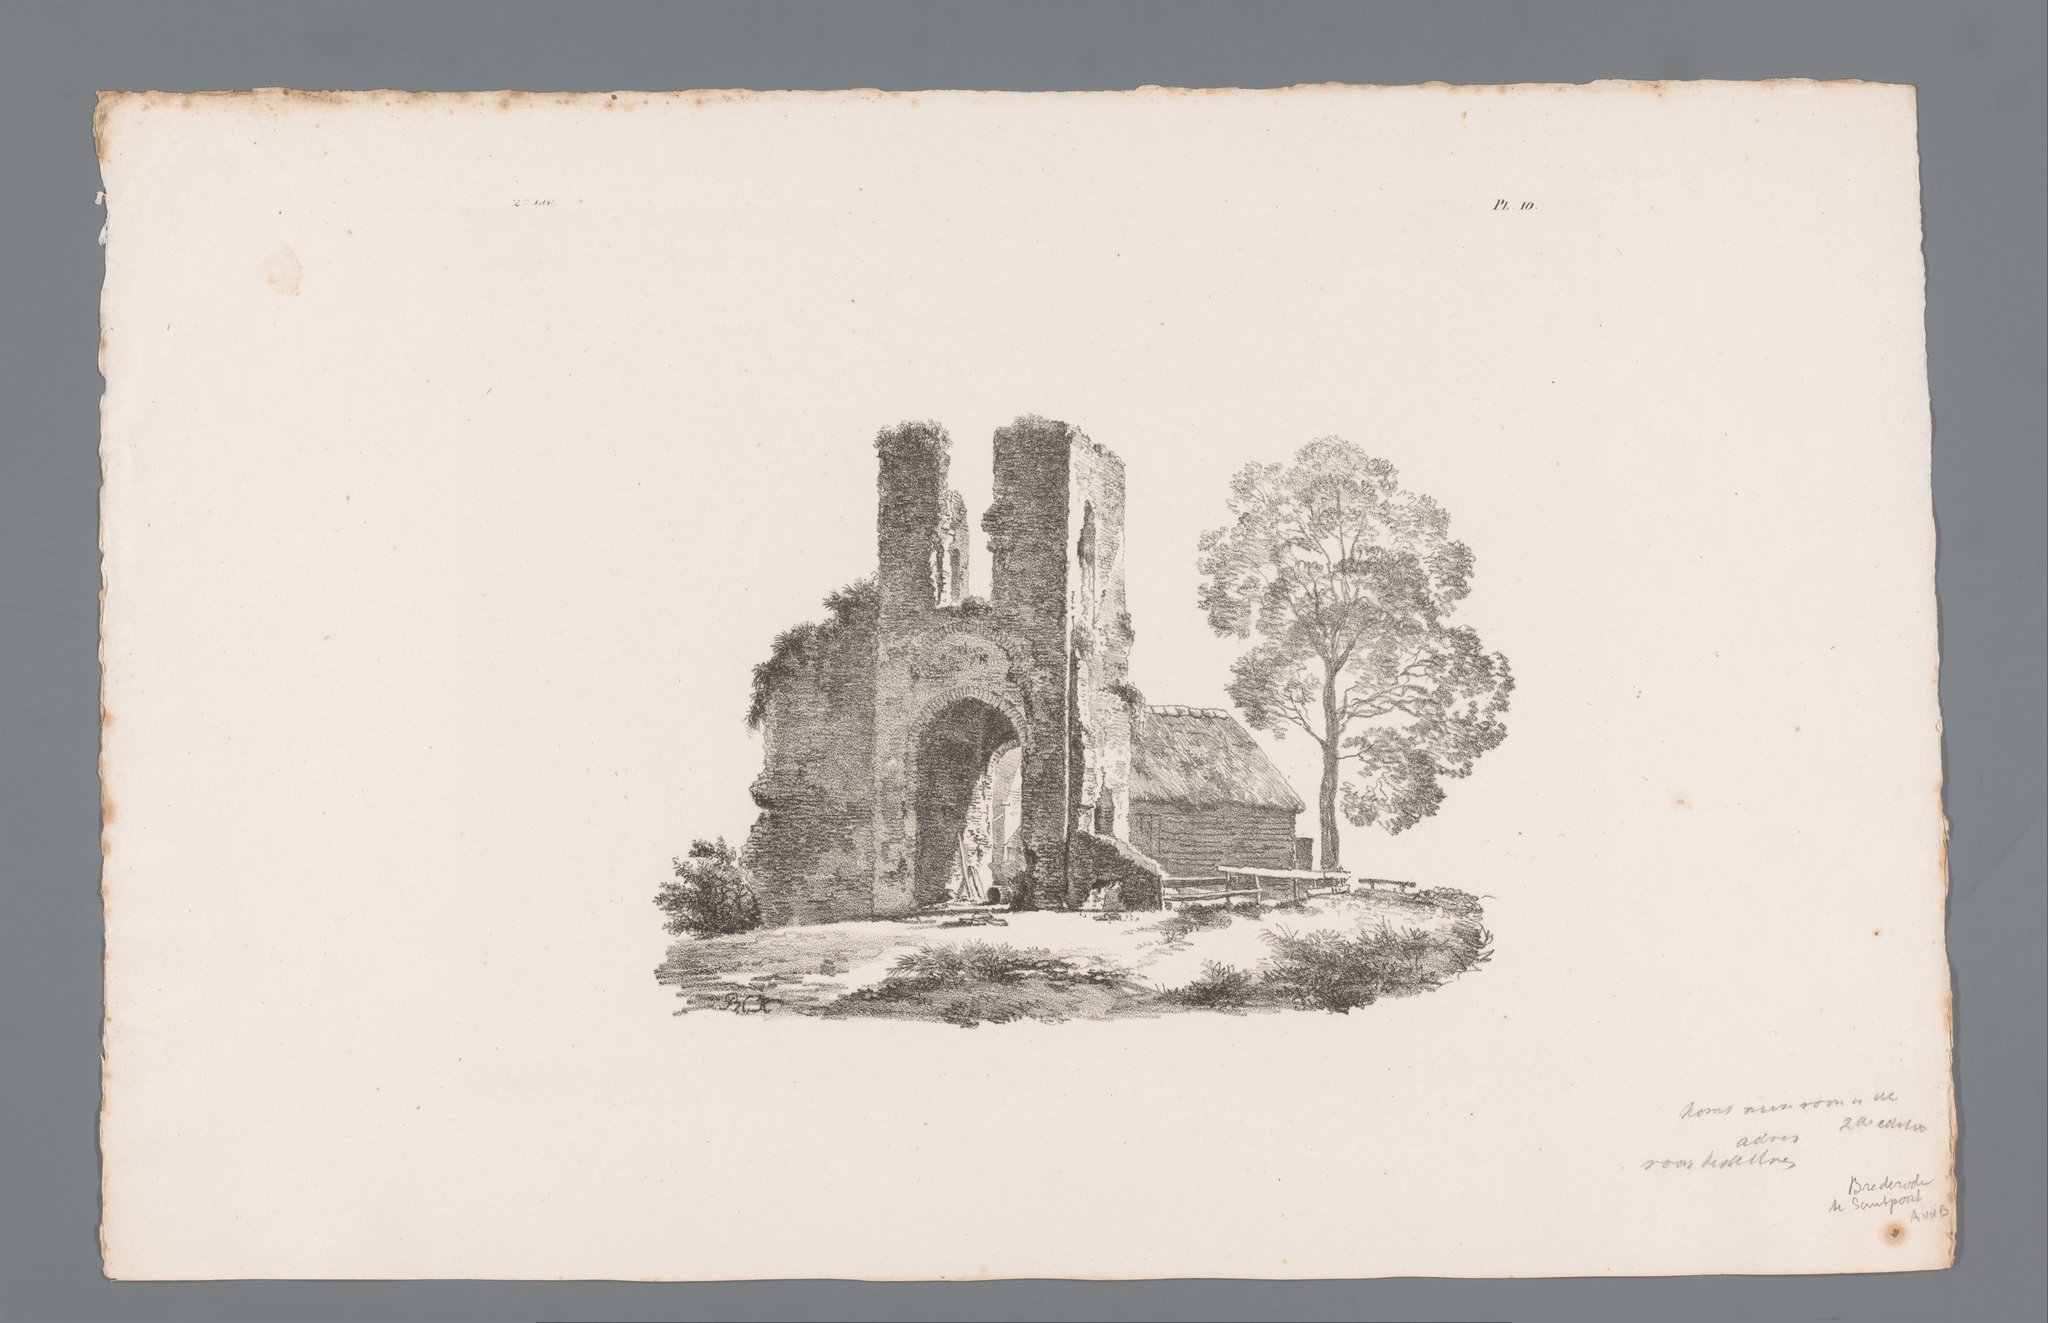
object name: print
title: Ruïne met boerderij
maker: barend cornelis koekkoek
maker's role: draughtsman, painter, print maker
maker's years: 1803-1862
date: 1829-1844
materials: paper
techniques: lithograph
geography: amsterdam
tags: ruin of a building ~ architecture, farm (building)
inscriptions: inscription: ‘Komt niet voor in de / 2e editie / adres / voor het adres / Brederode / te Santpoort / AvdB’, collector's mark: Lugt 2228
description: In 1829 en 1830 gaf Koekkoek, samen met Daiwaille, zes cahiers uit met ieder zes prenten getiteld Landschapstudiën. Deze werden gebruikt in het tekenonderwijs. Vijftien jaar later werd deze reeks, in een andere samenstelling nogmaals uitgegeven door Meyer en Comp in Amsterdam. Zie: De Bruyn Kops, 1963.